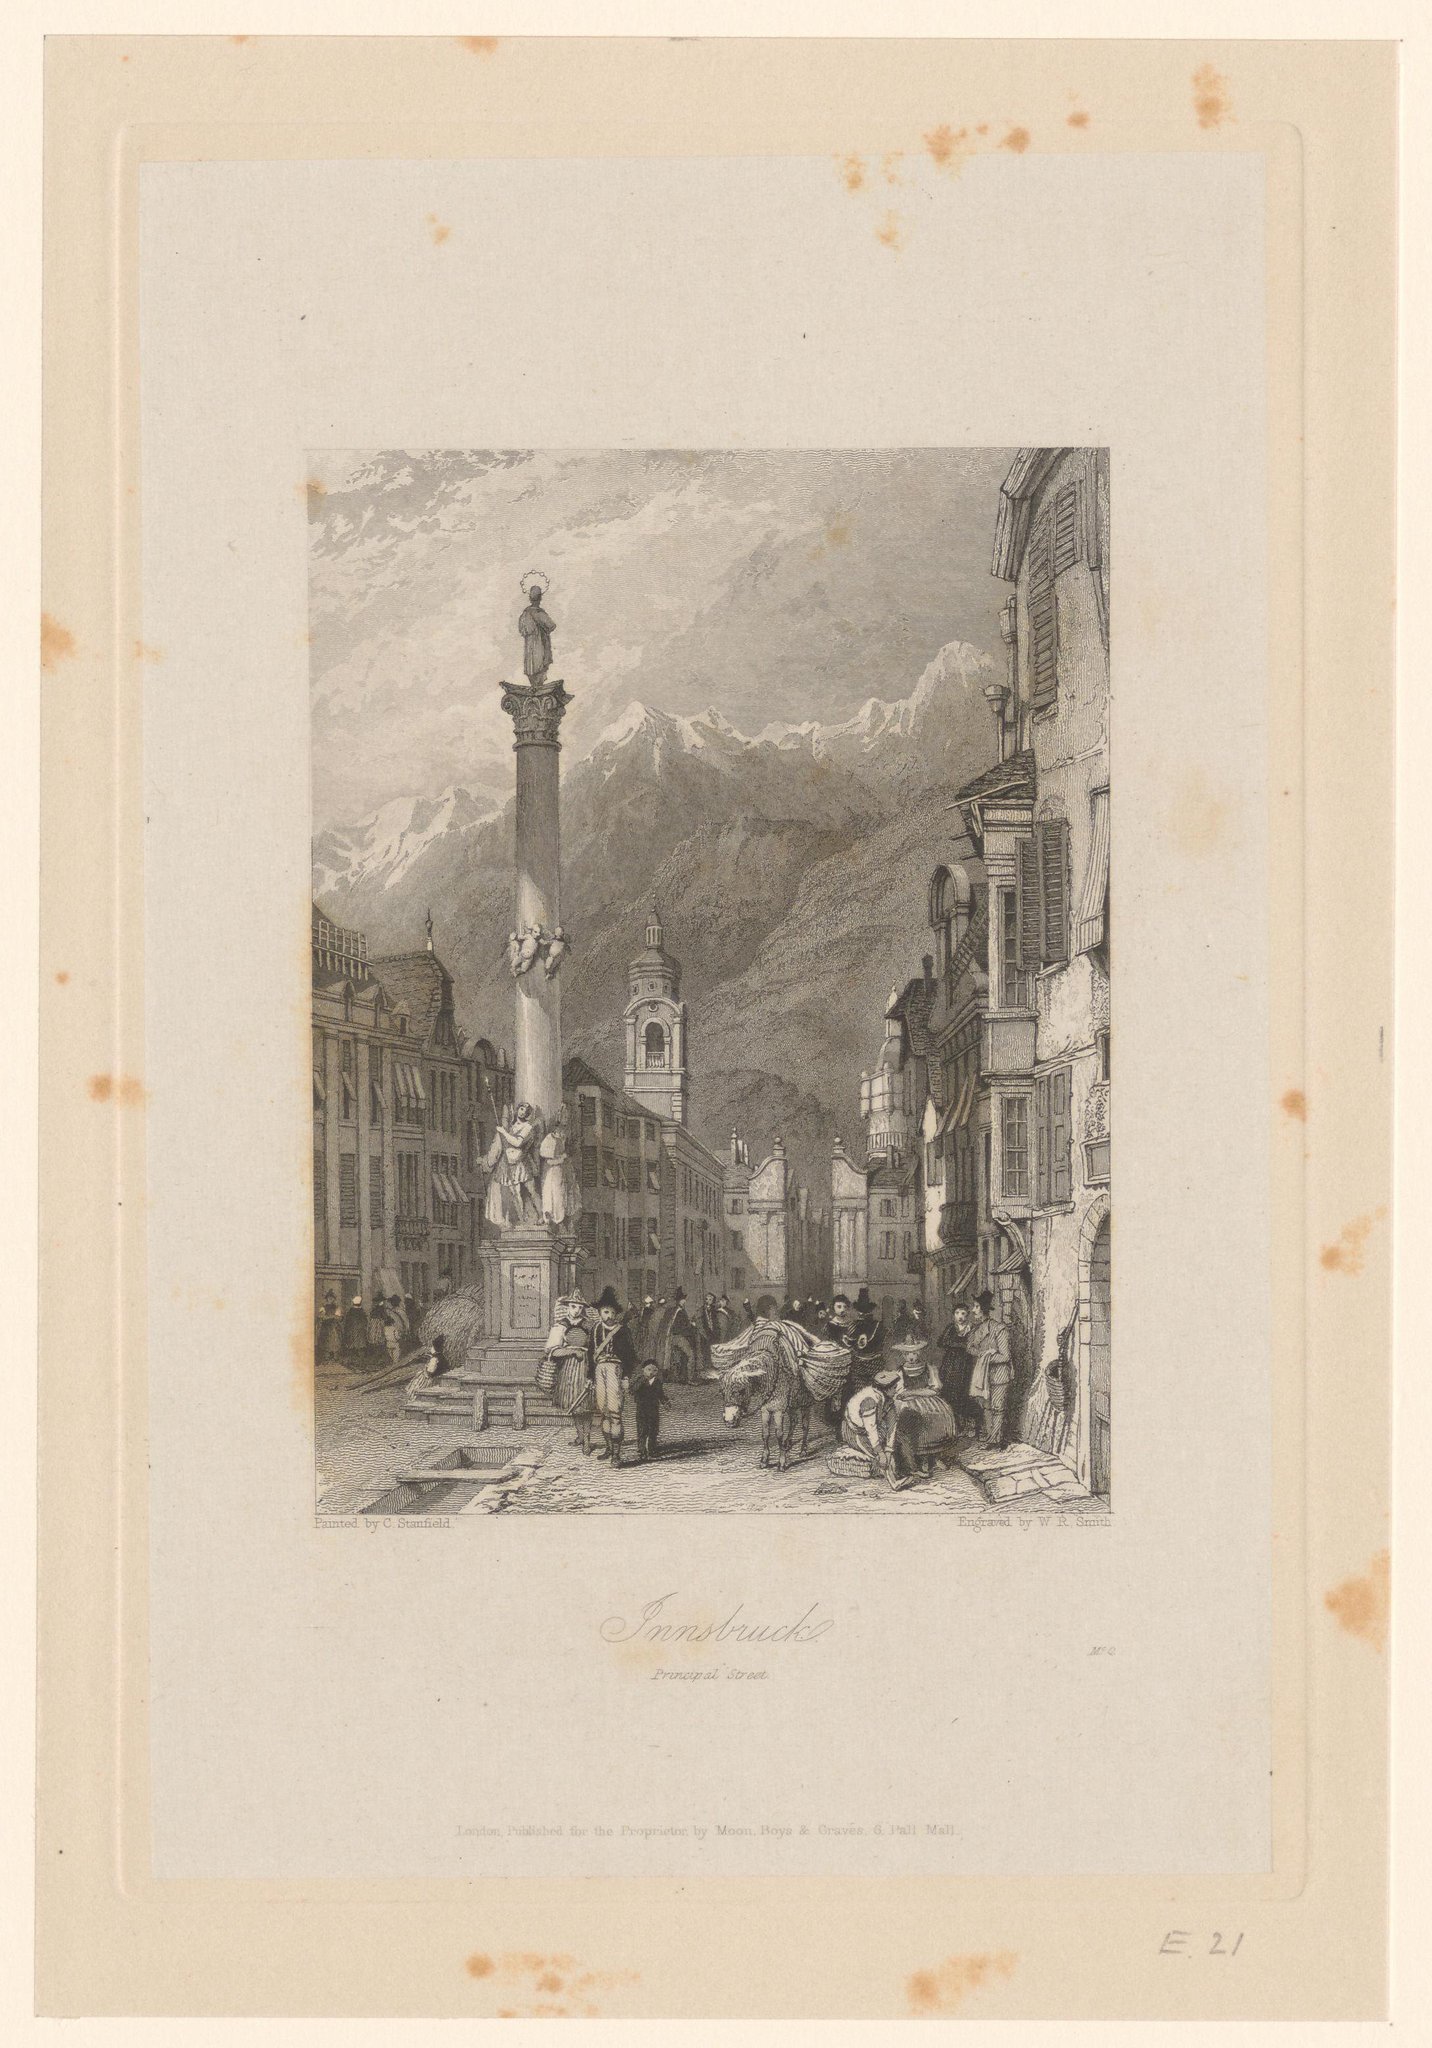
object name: print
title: Gezicht op de tegenwoordige Maria-Theresien-Straße te Innsbruck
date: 1832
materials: paper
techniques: etching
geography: london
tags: street (+ city(-scape) with figures, staffage), mountains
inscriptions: collector's mark: Lugt 2228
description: Huidige staat van prent mogelijk gebruikt in: Heath's Picturesque Annual. Travelling sketches in the north of Italy, the Tyrol and on the Rhine (...). Londen: Longman et al., 1832.